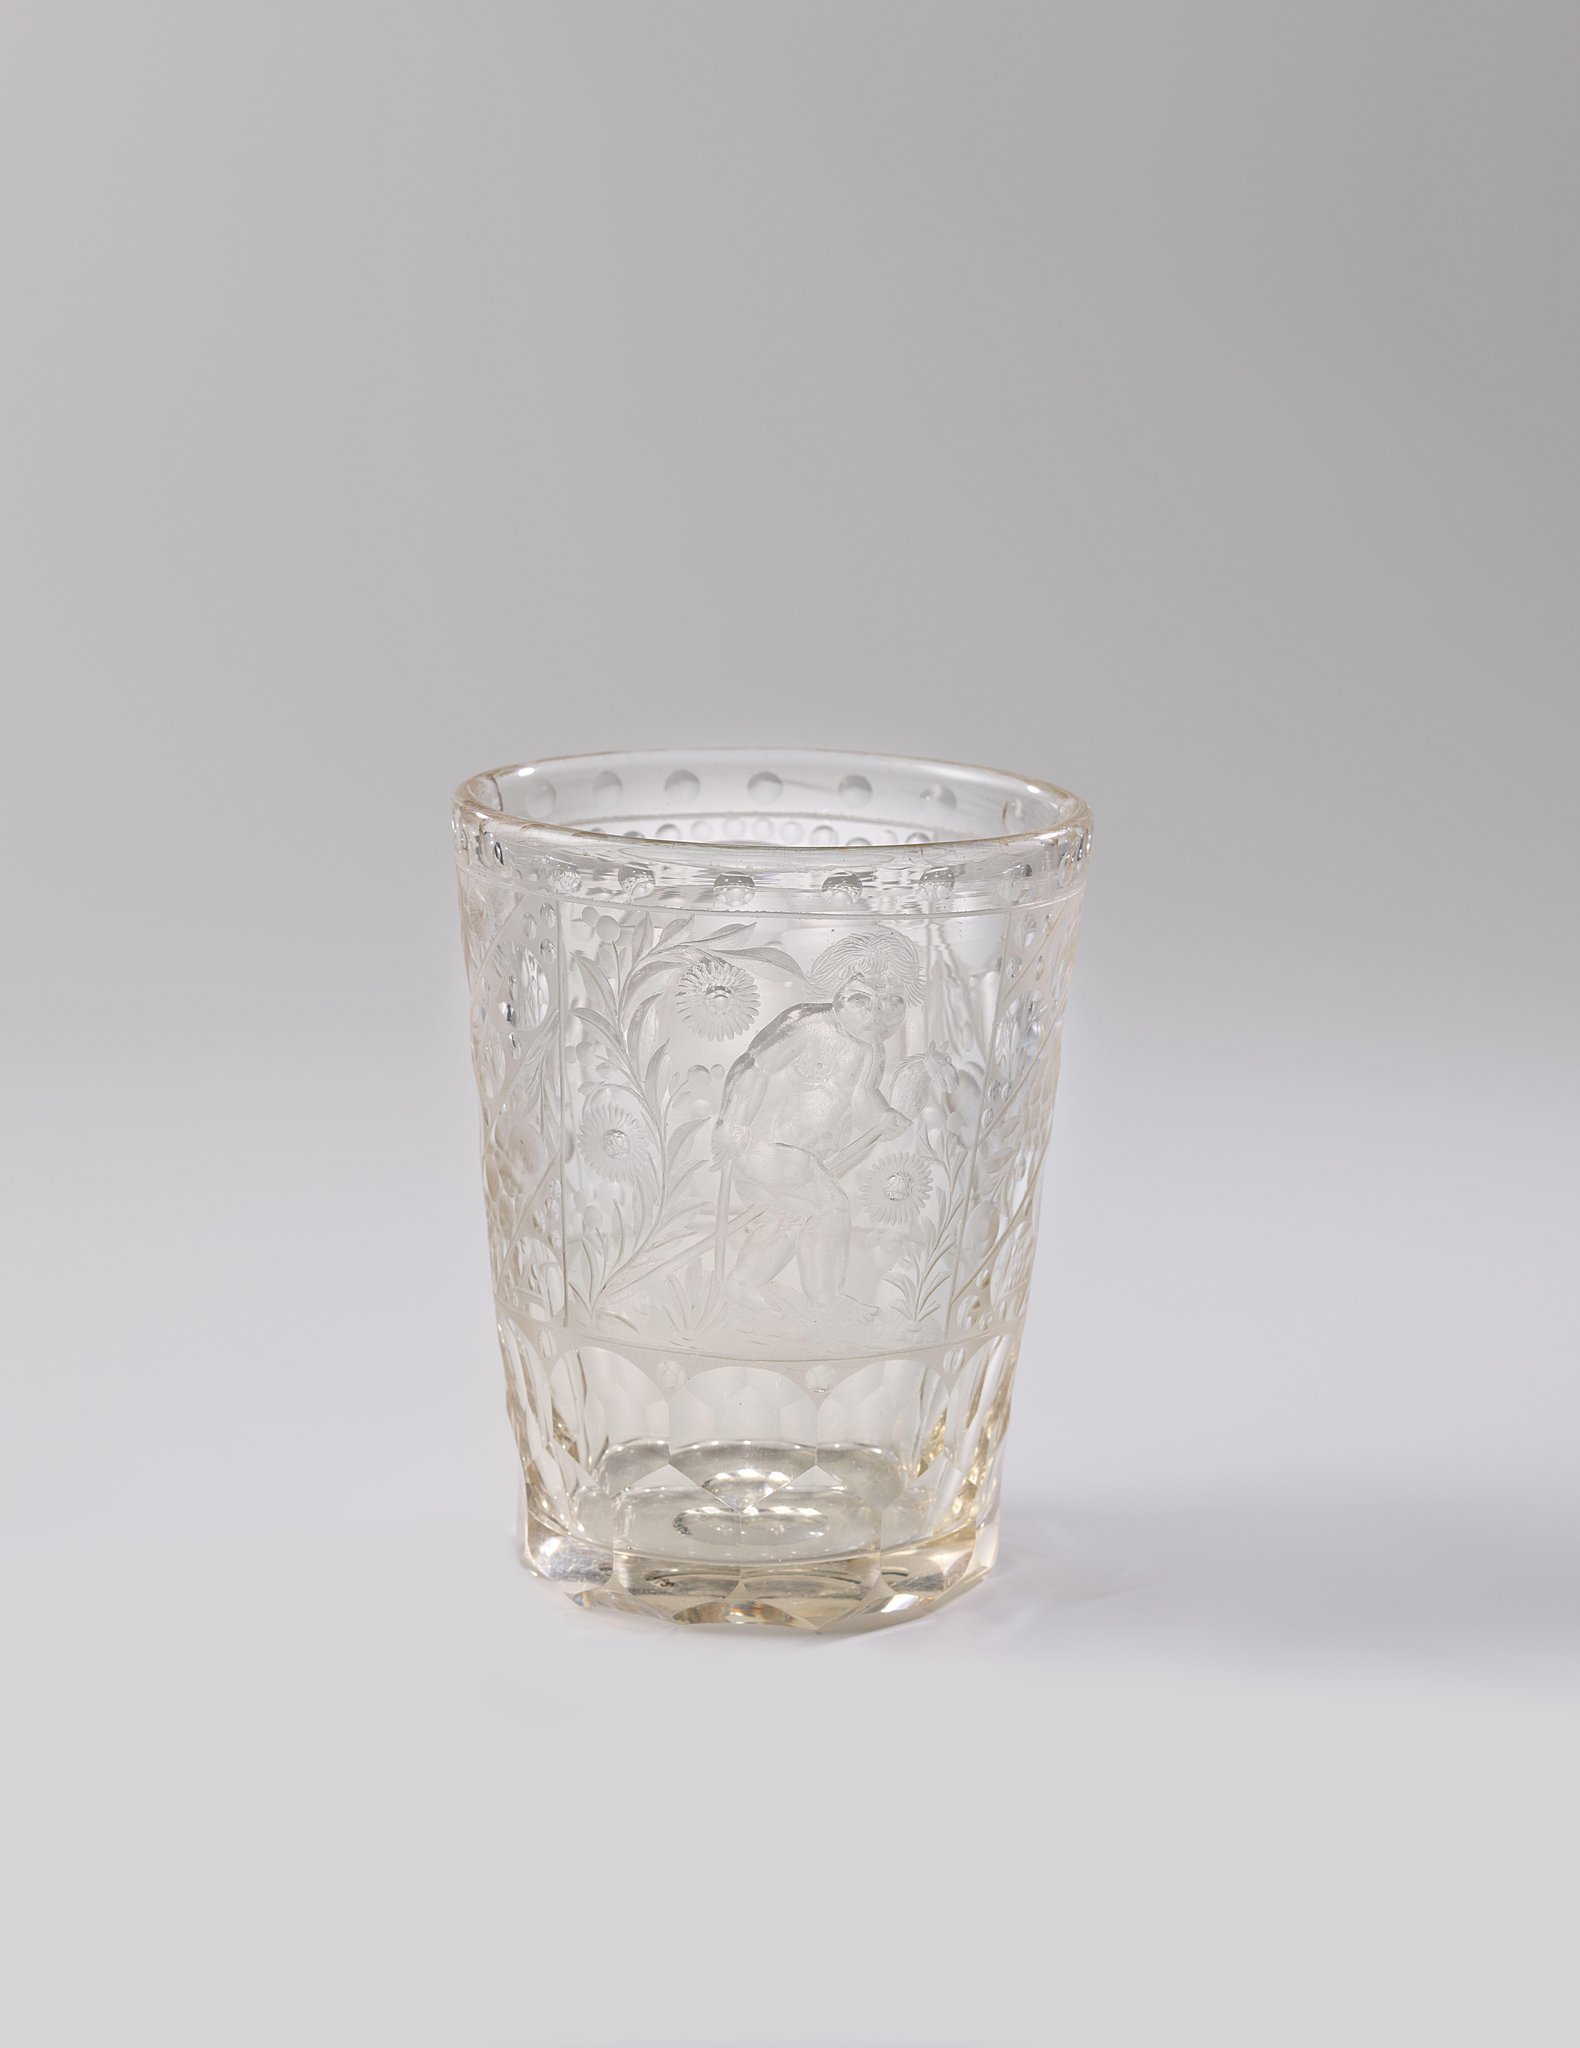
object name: cup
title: Beker met een putto op een stokpaard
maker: Anonymous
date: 1725-1775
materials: glass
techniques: glassblowing, grinding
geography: bohemia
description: Beker van helder, kleurloos glas, met geslepen facetten en schijven, diep ingesneden en gepolijst, benevens een putto op een stokpaard, bloemen en vruchten.